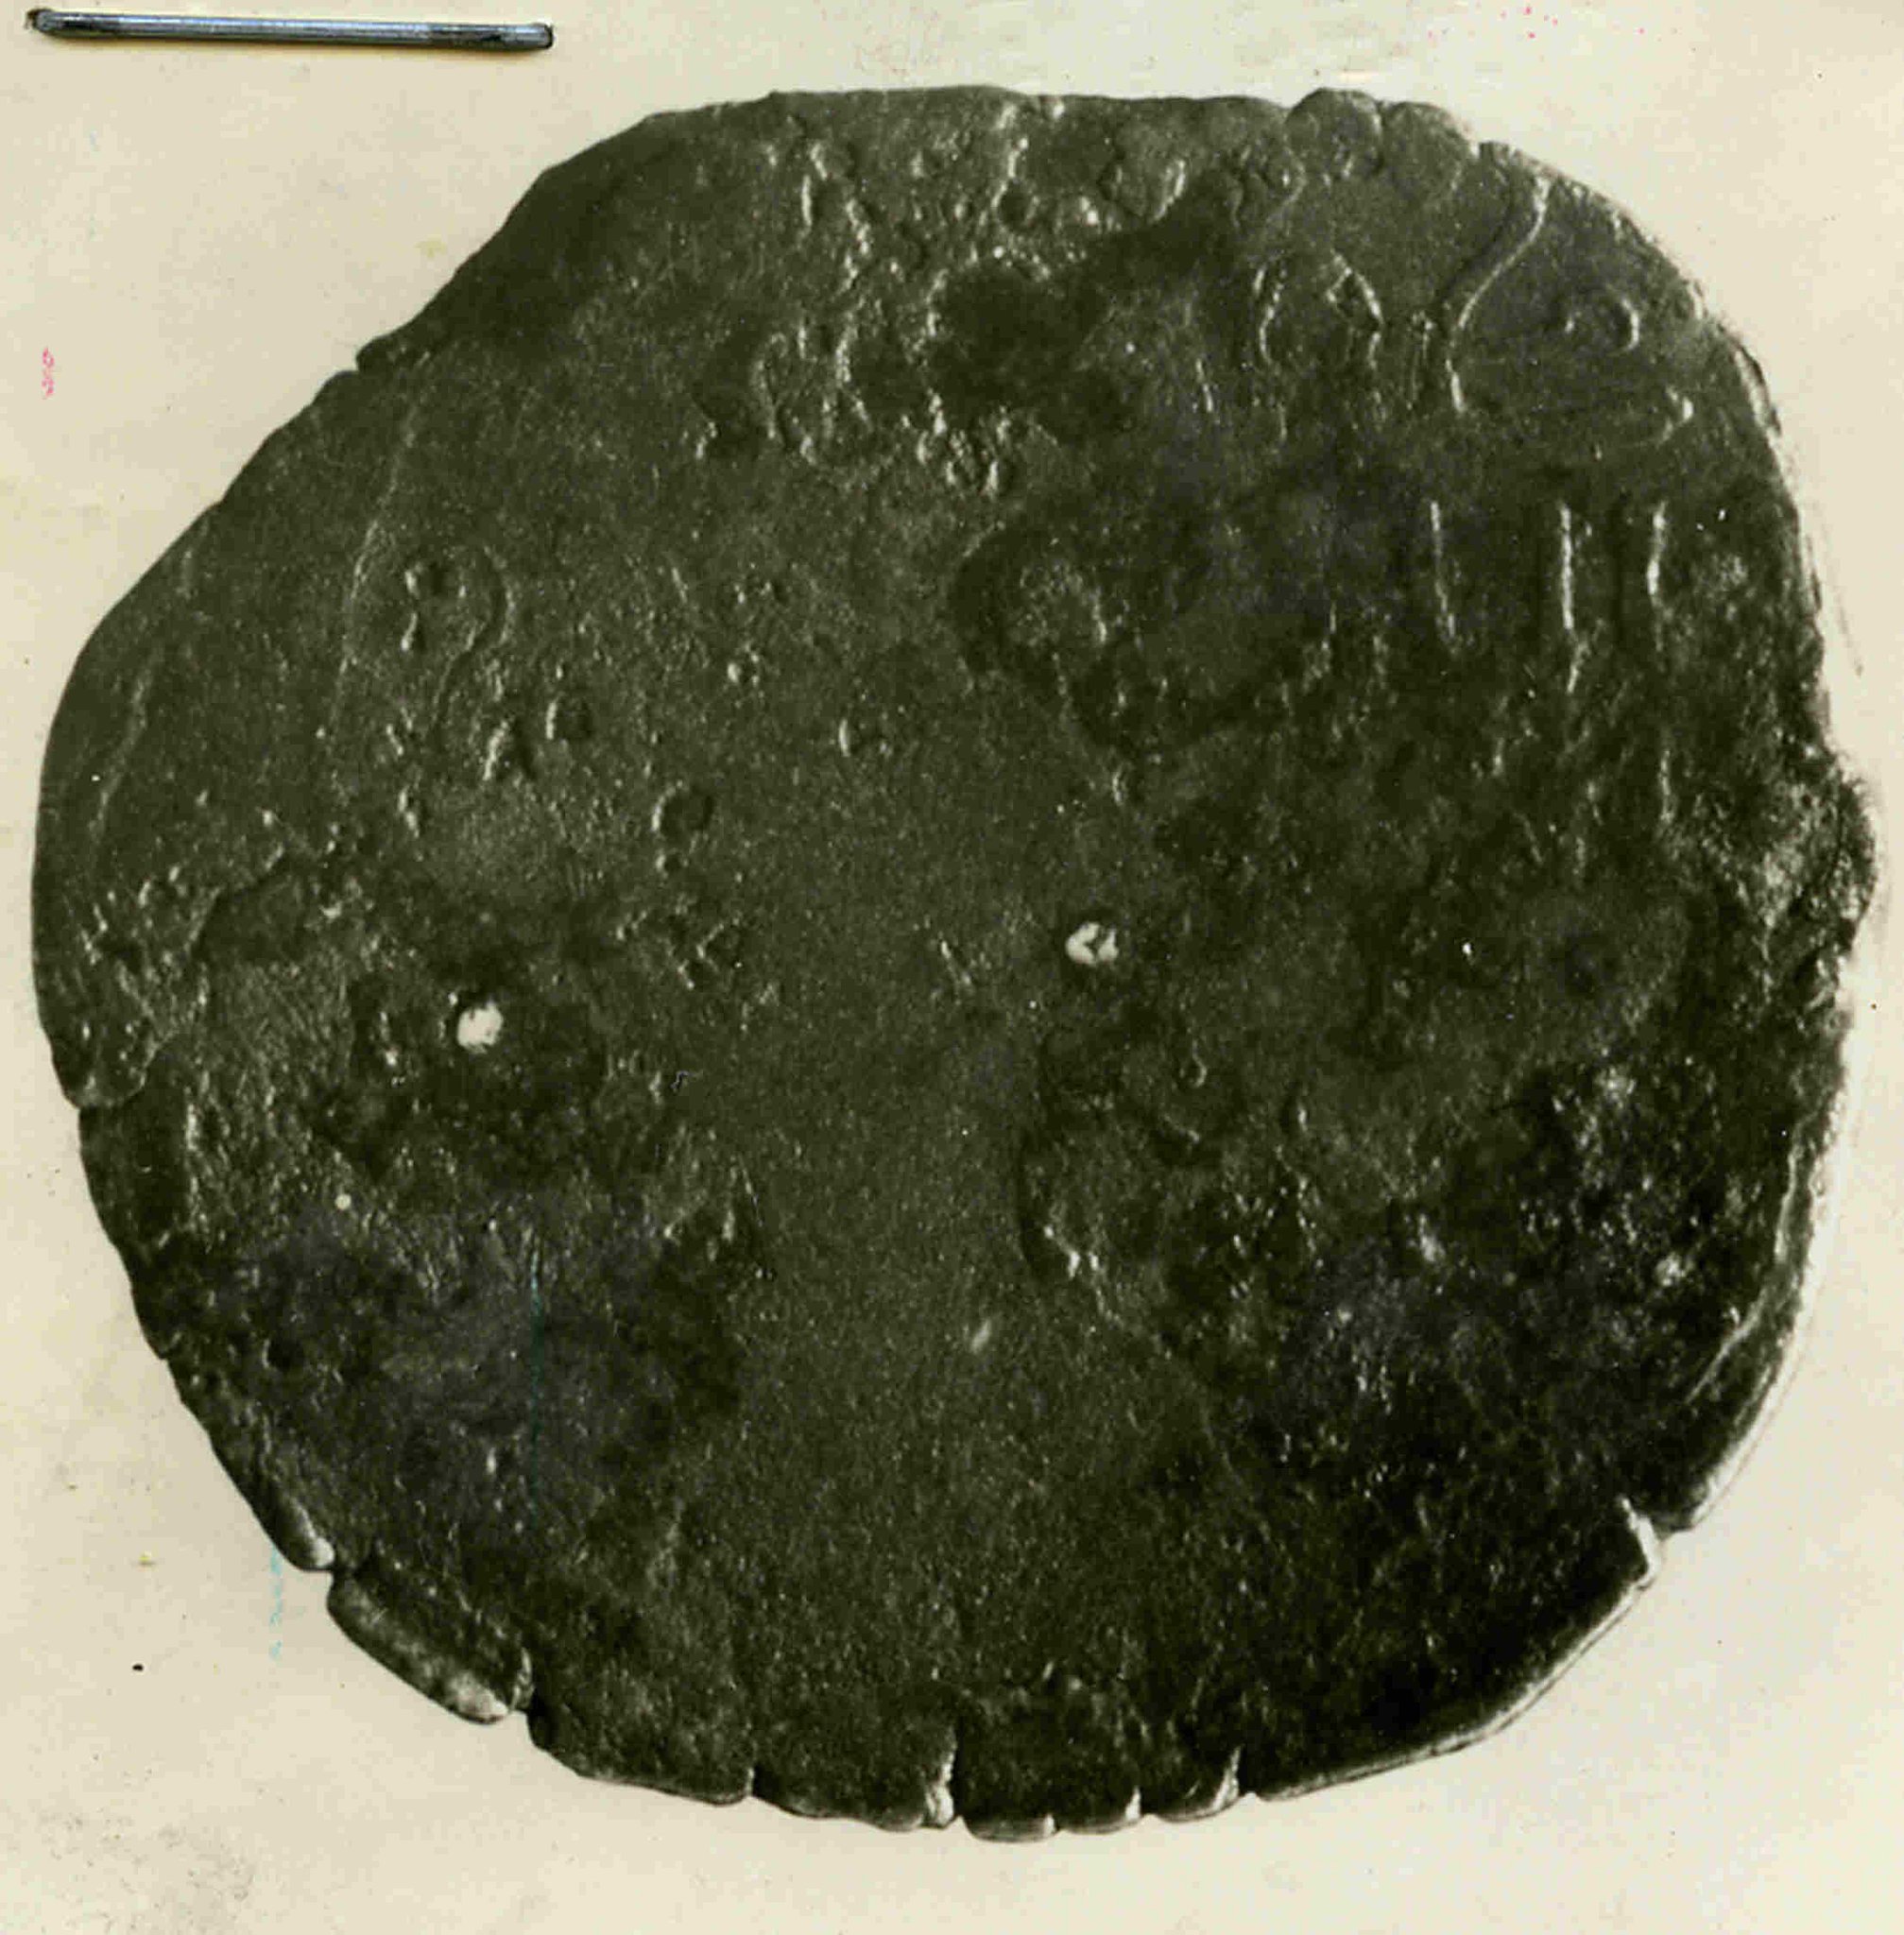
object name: coin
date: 1101-1200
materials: copper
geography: iran